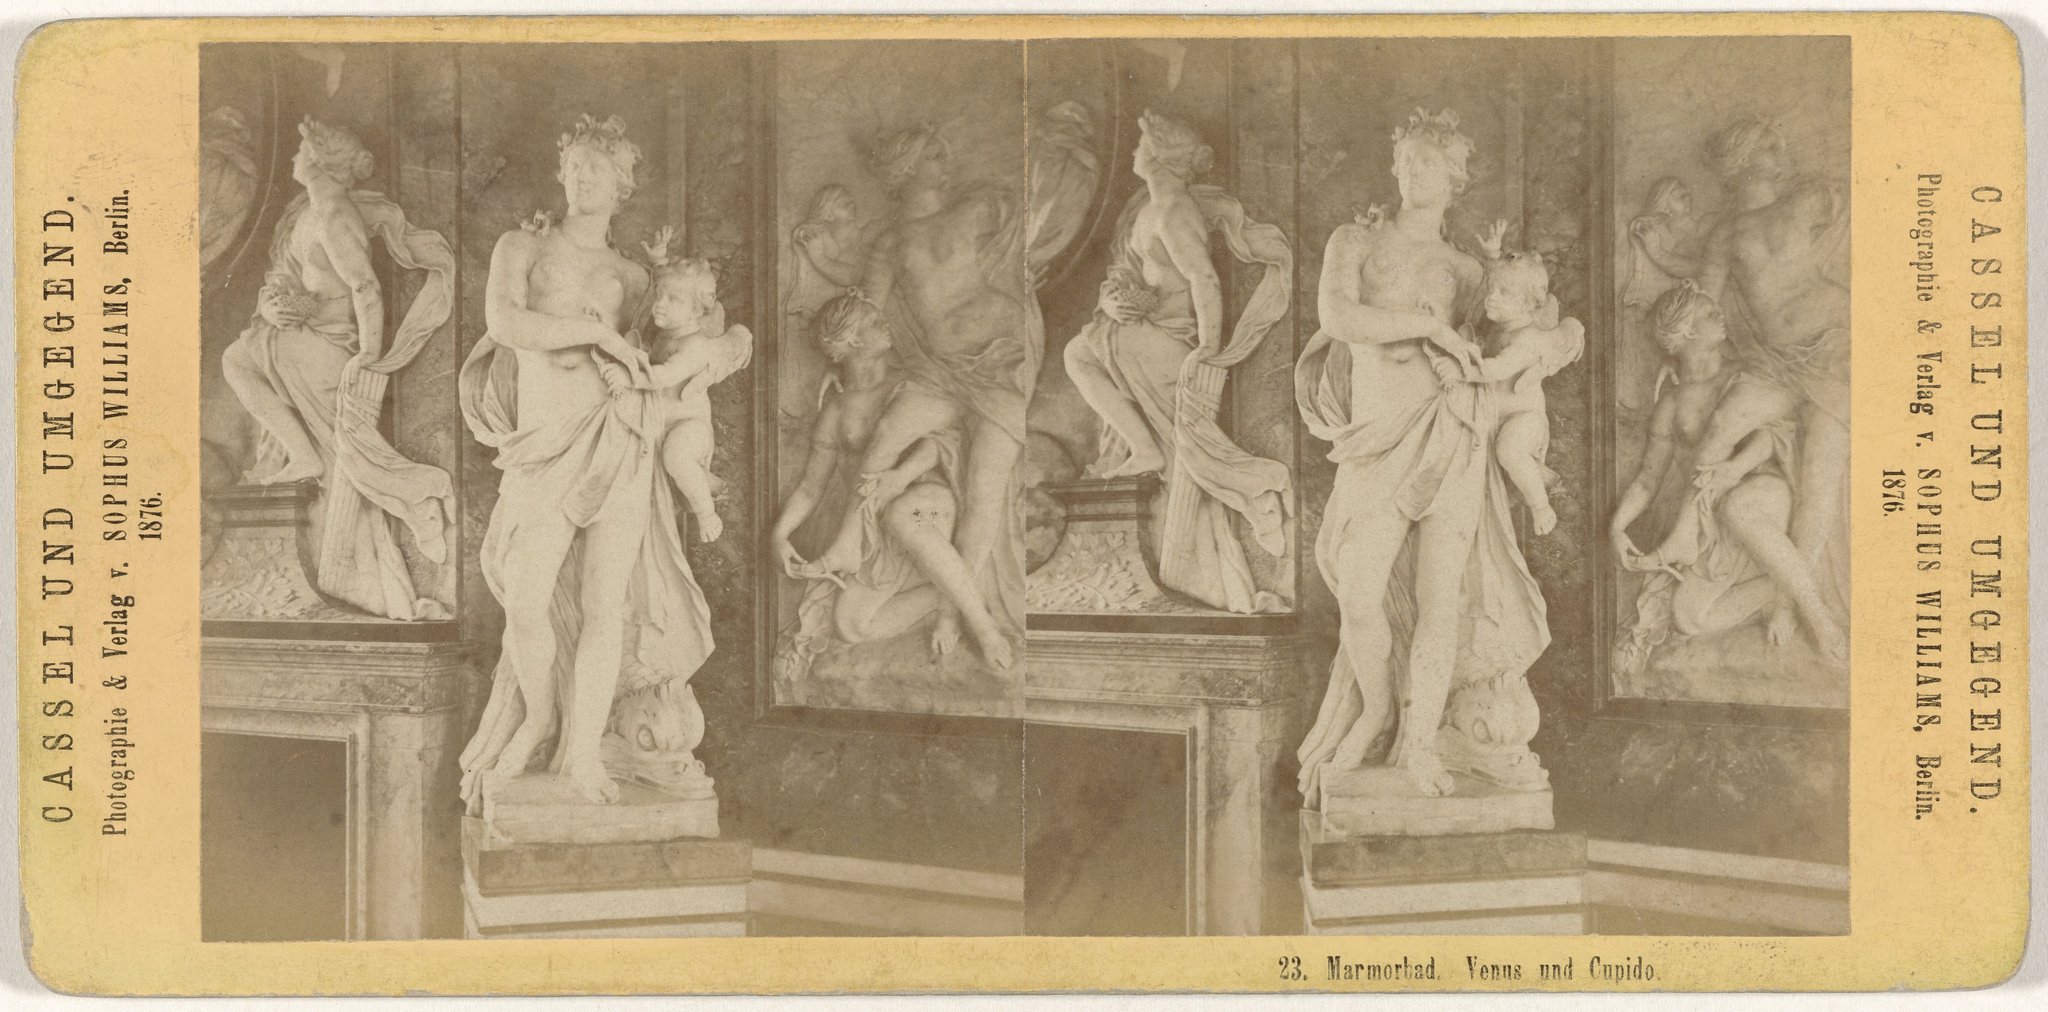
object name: stereograph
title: Cassel und Umgegend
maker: sophus williams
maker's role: publisher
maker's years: 1835-1900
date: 1876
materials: cardboard, paper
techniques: albumen print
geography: kassel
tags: venus taking care of cupid, sculpture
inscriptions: number: ‘23.’